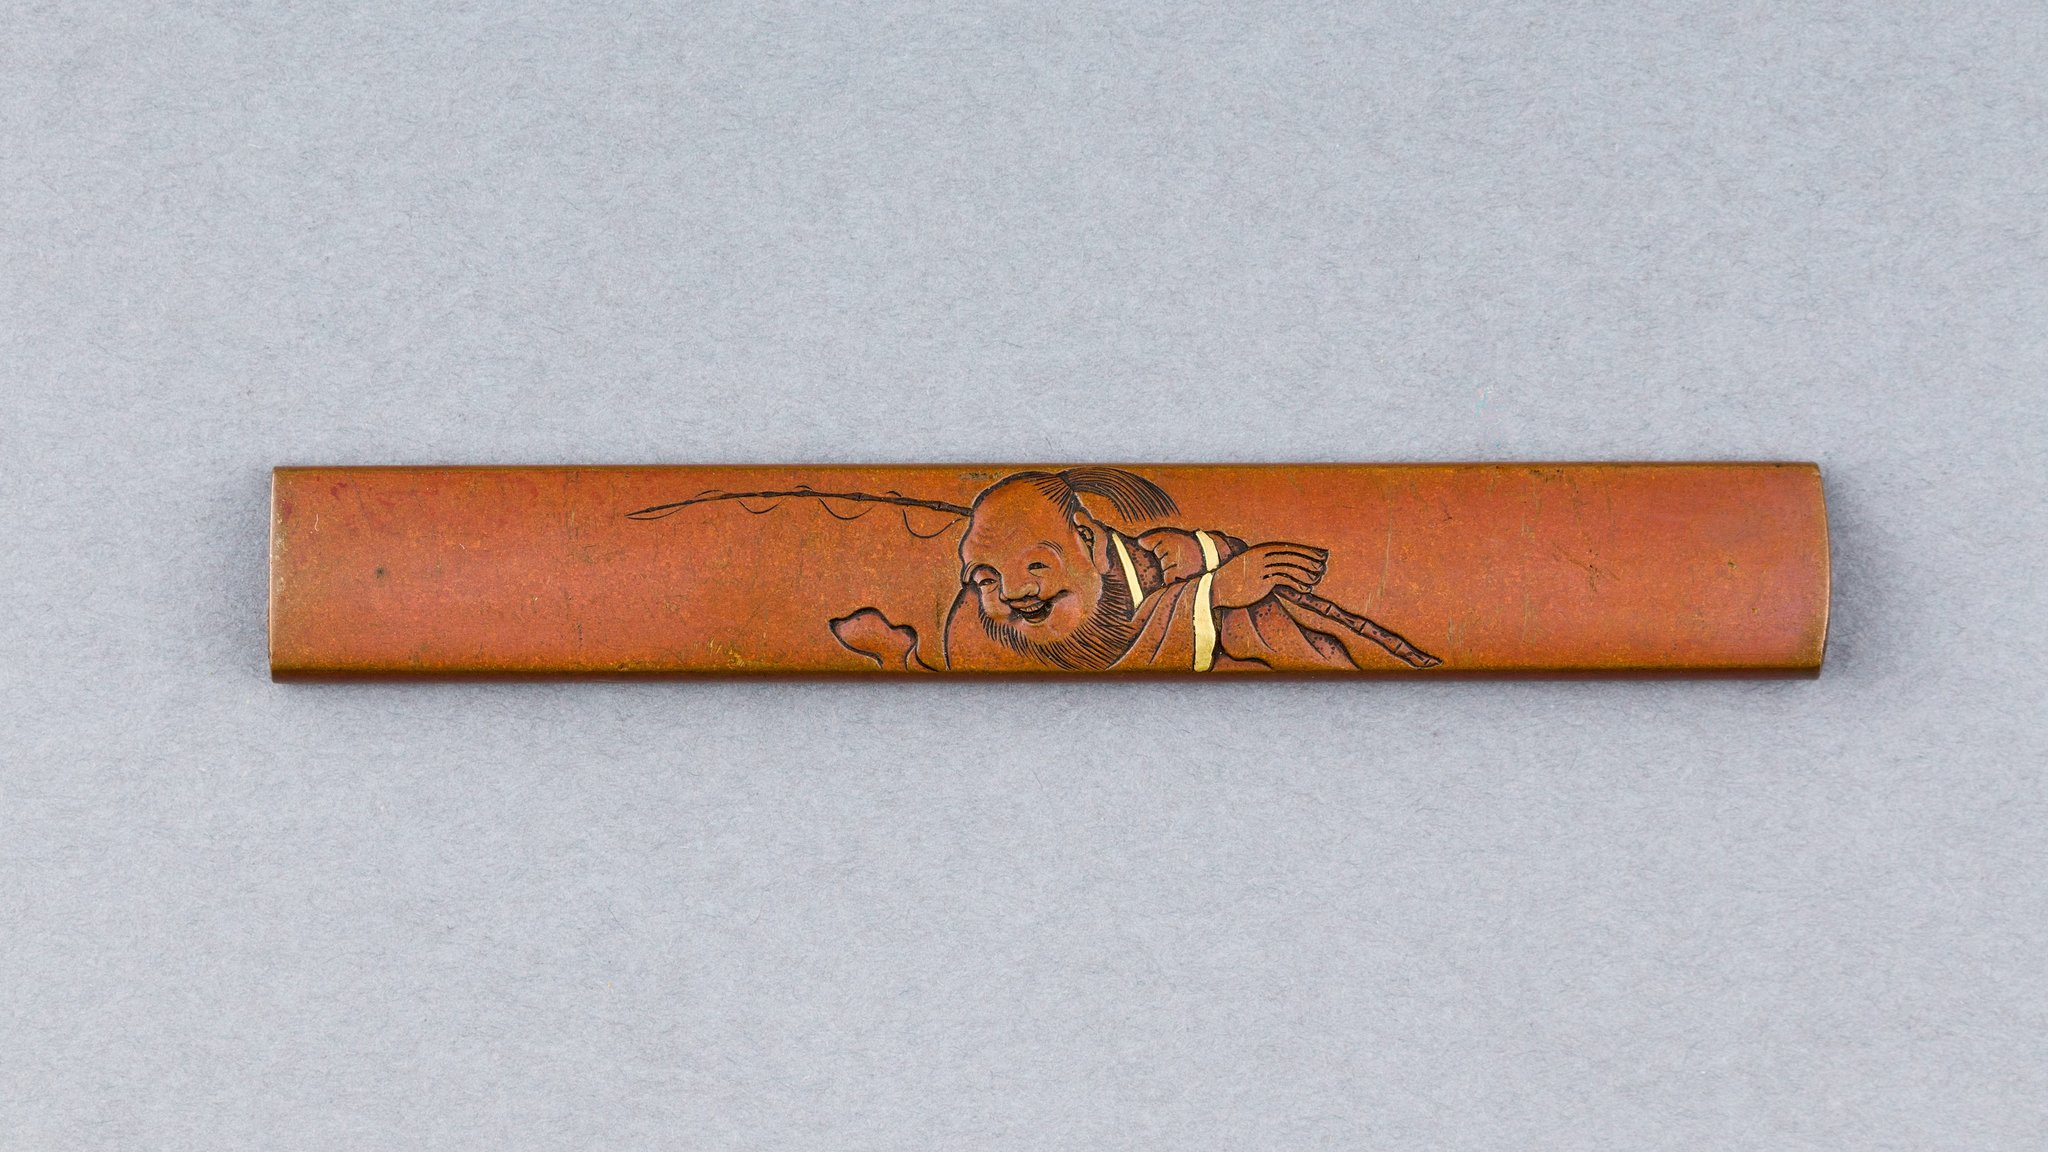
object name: knife handle kozuka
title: Knife Handle (Kozuka)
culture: japanese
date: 1615-1868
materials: copper, gold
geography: japan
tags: men